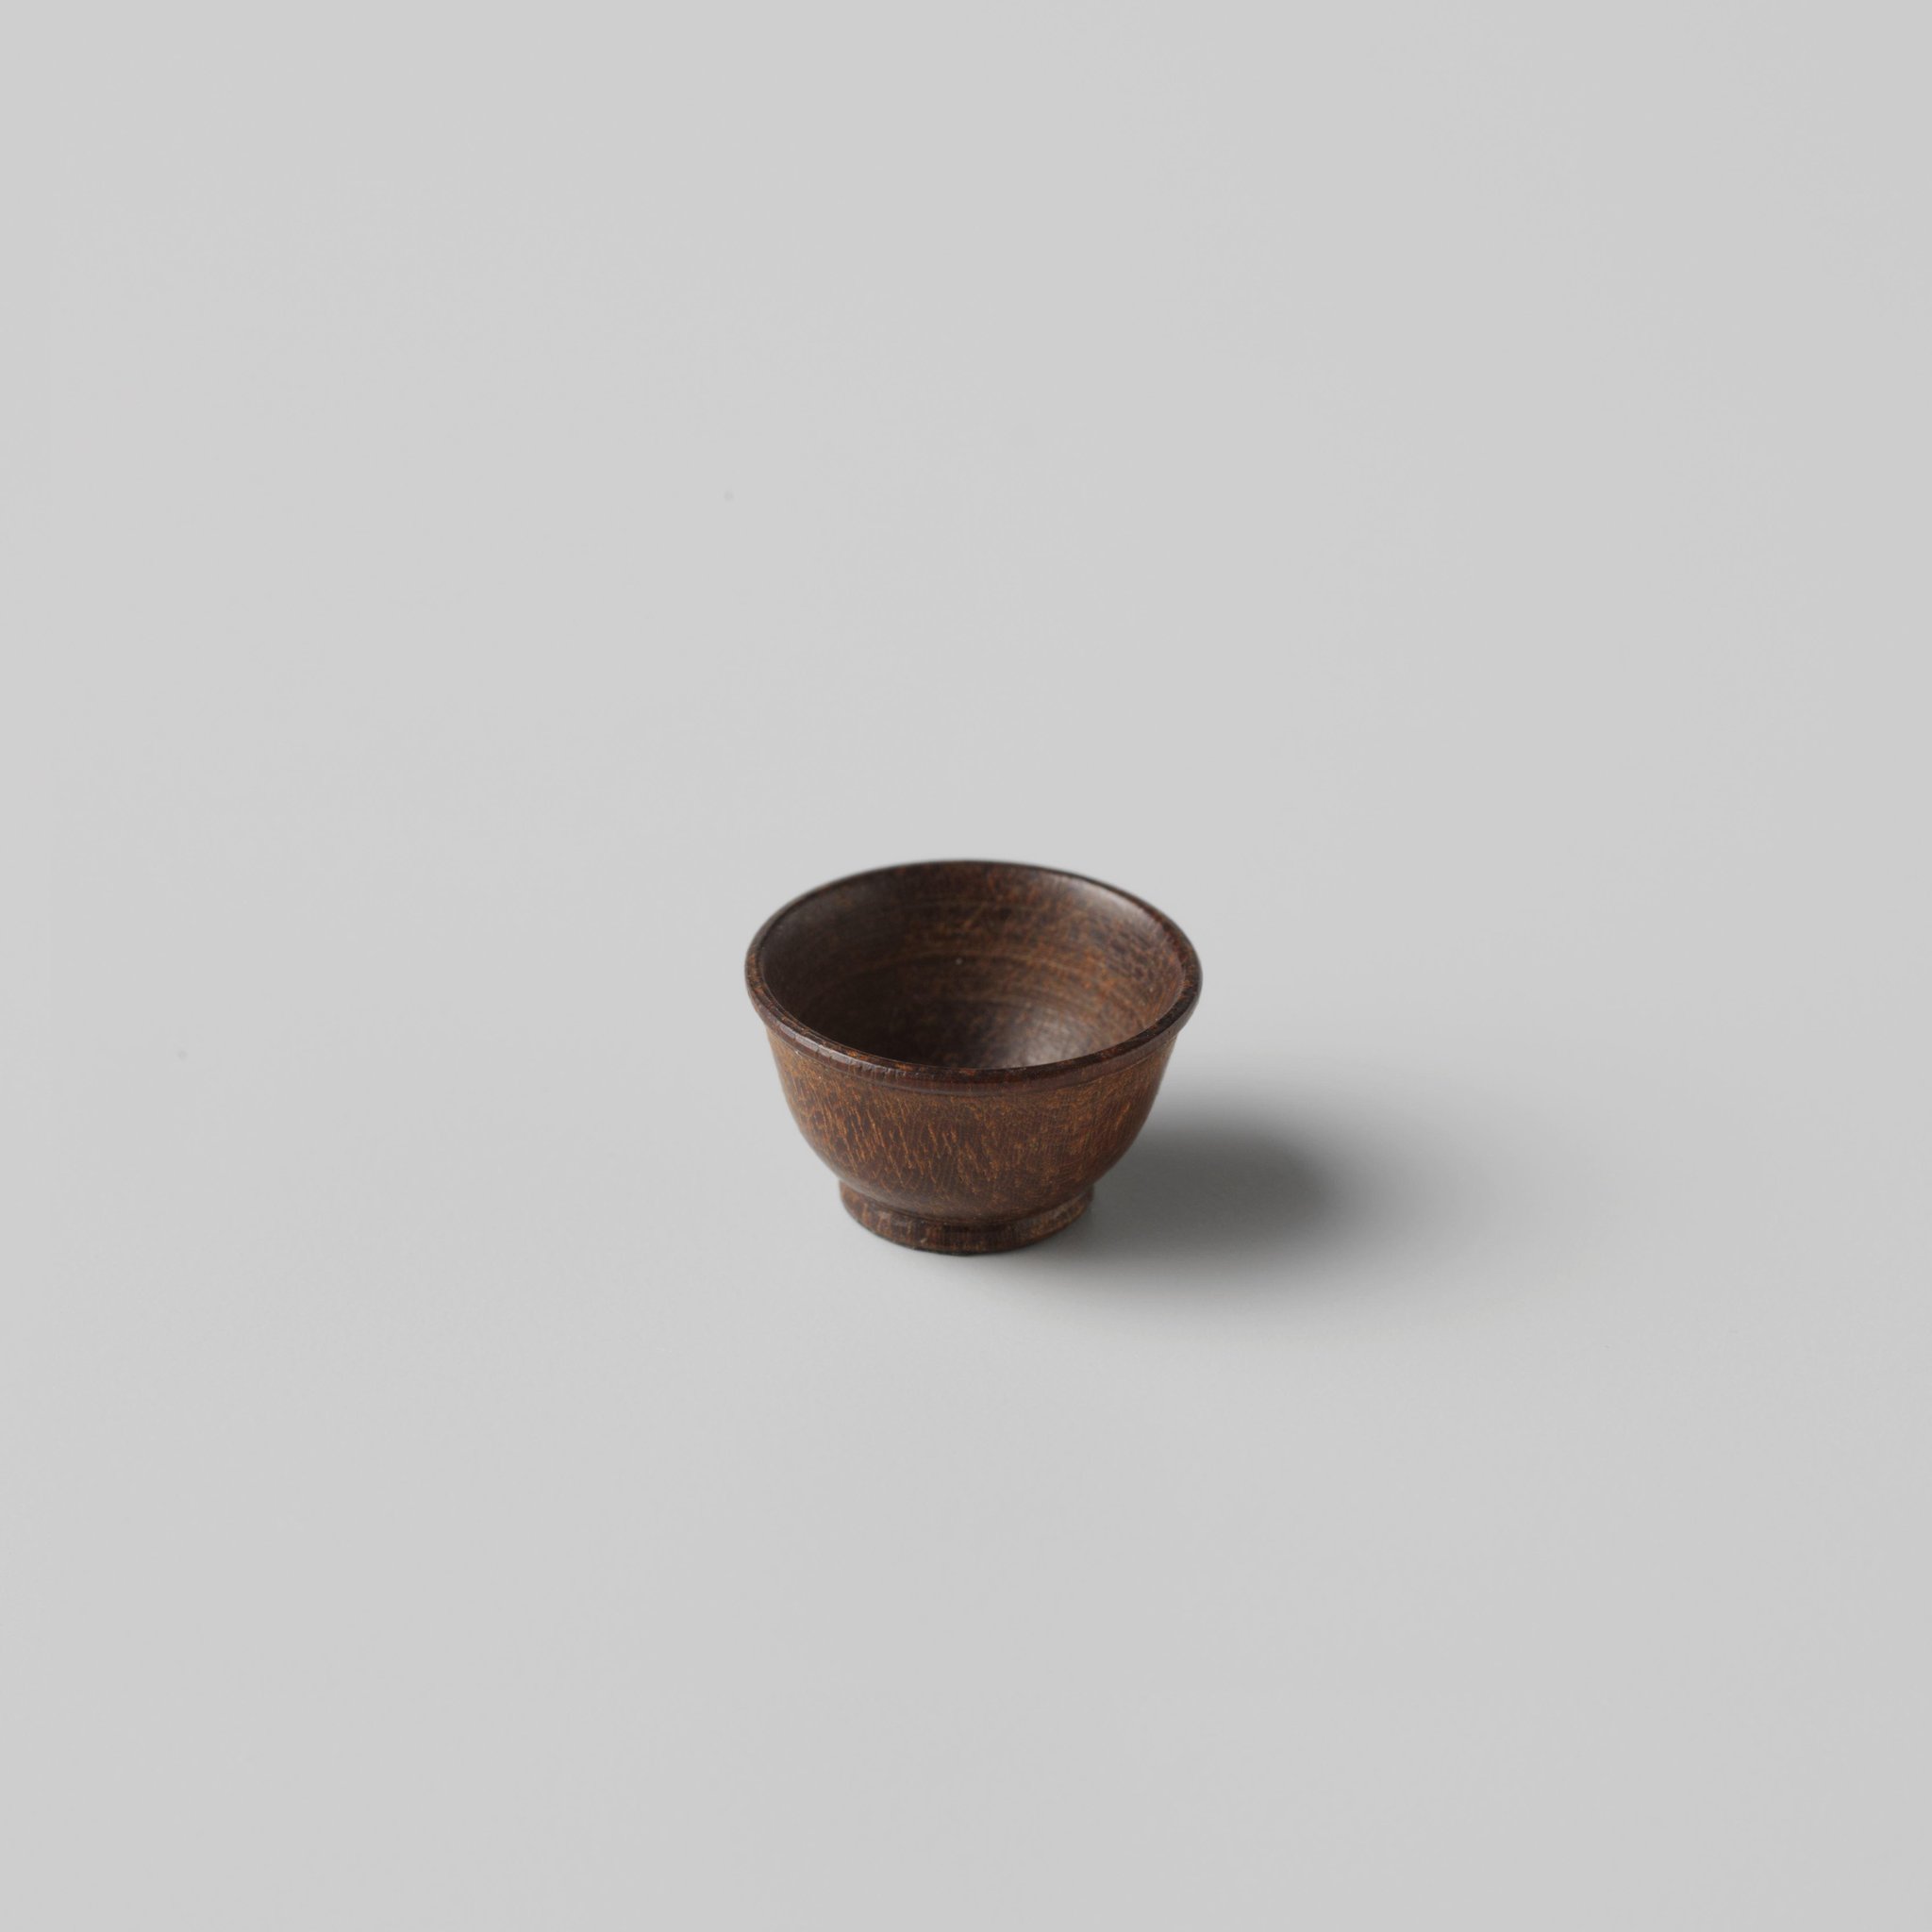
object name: tea cup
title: Theekop van gedraaid hout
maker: Anonymous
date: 1800-1899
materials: wood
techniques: tropisch hardhout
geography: england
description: Vier koppen gedraaid van een donkere hardhoutsoort.